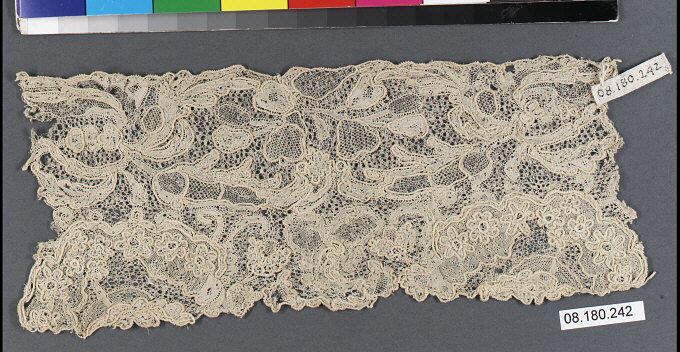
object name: fragment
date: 1701-1800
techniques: lace